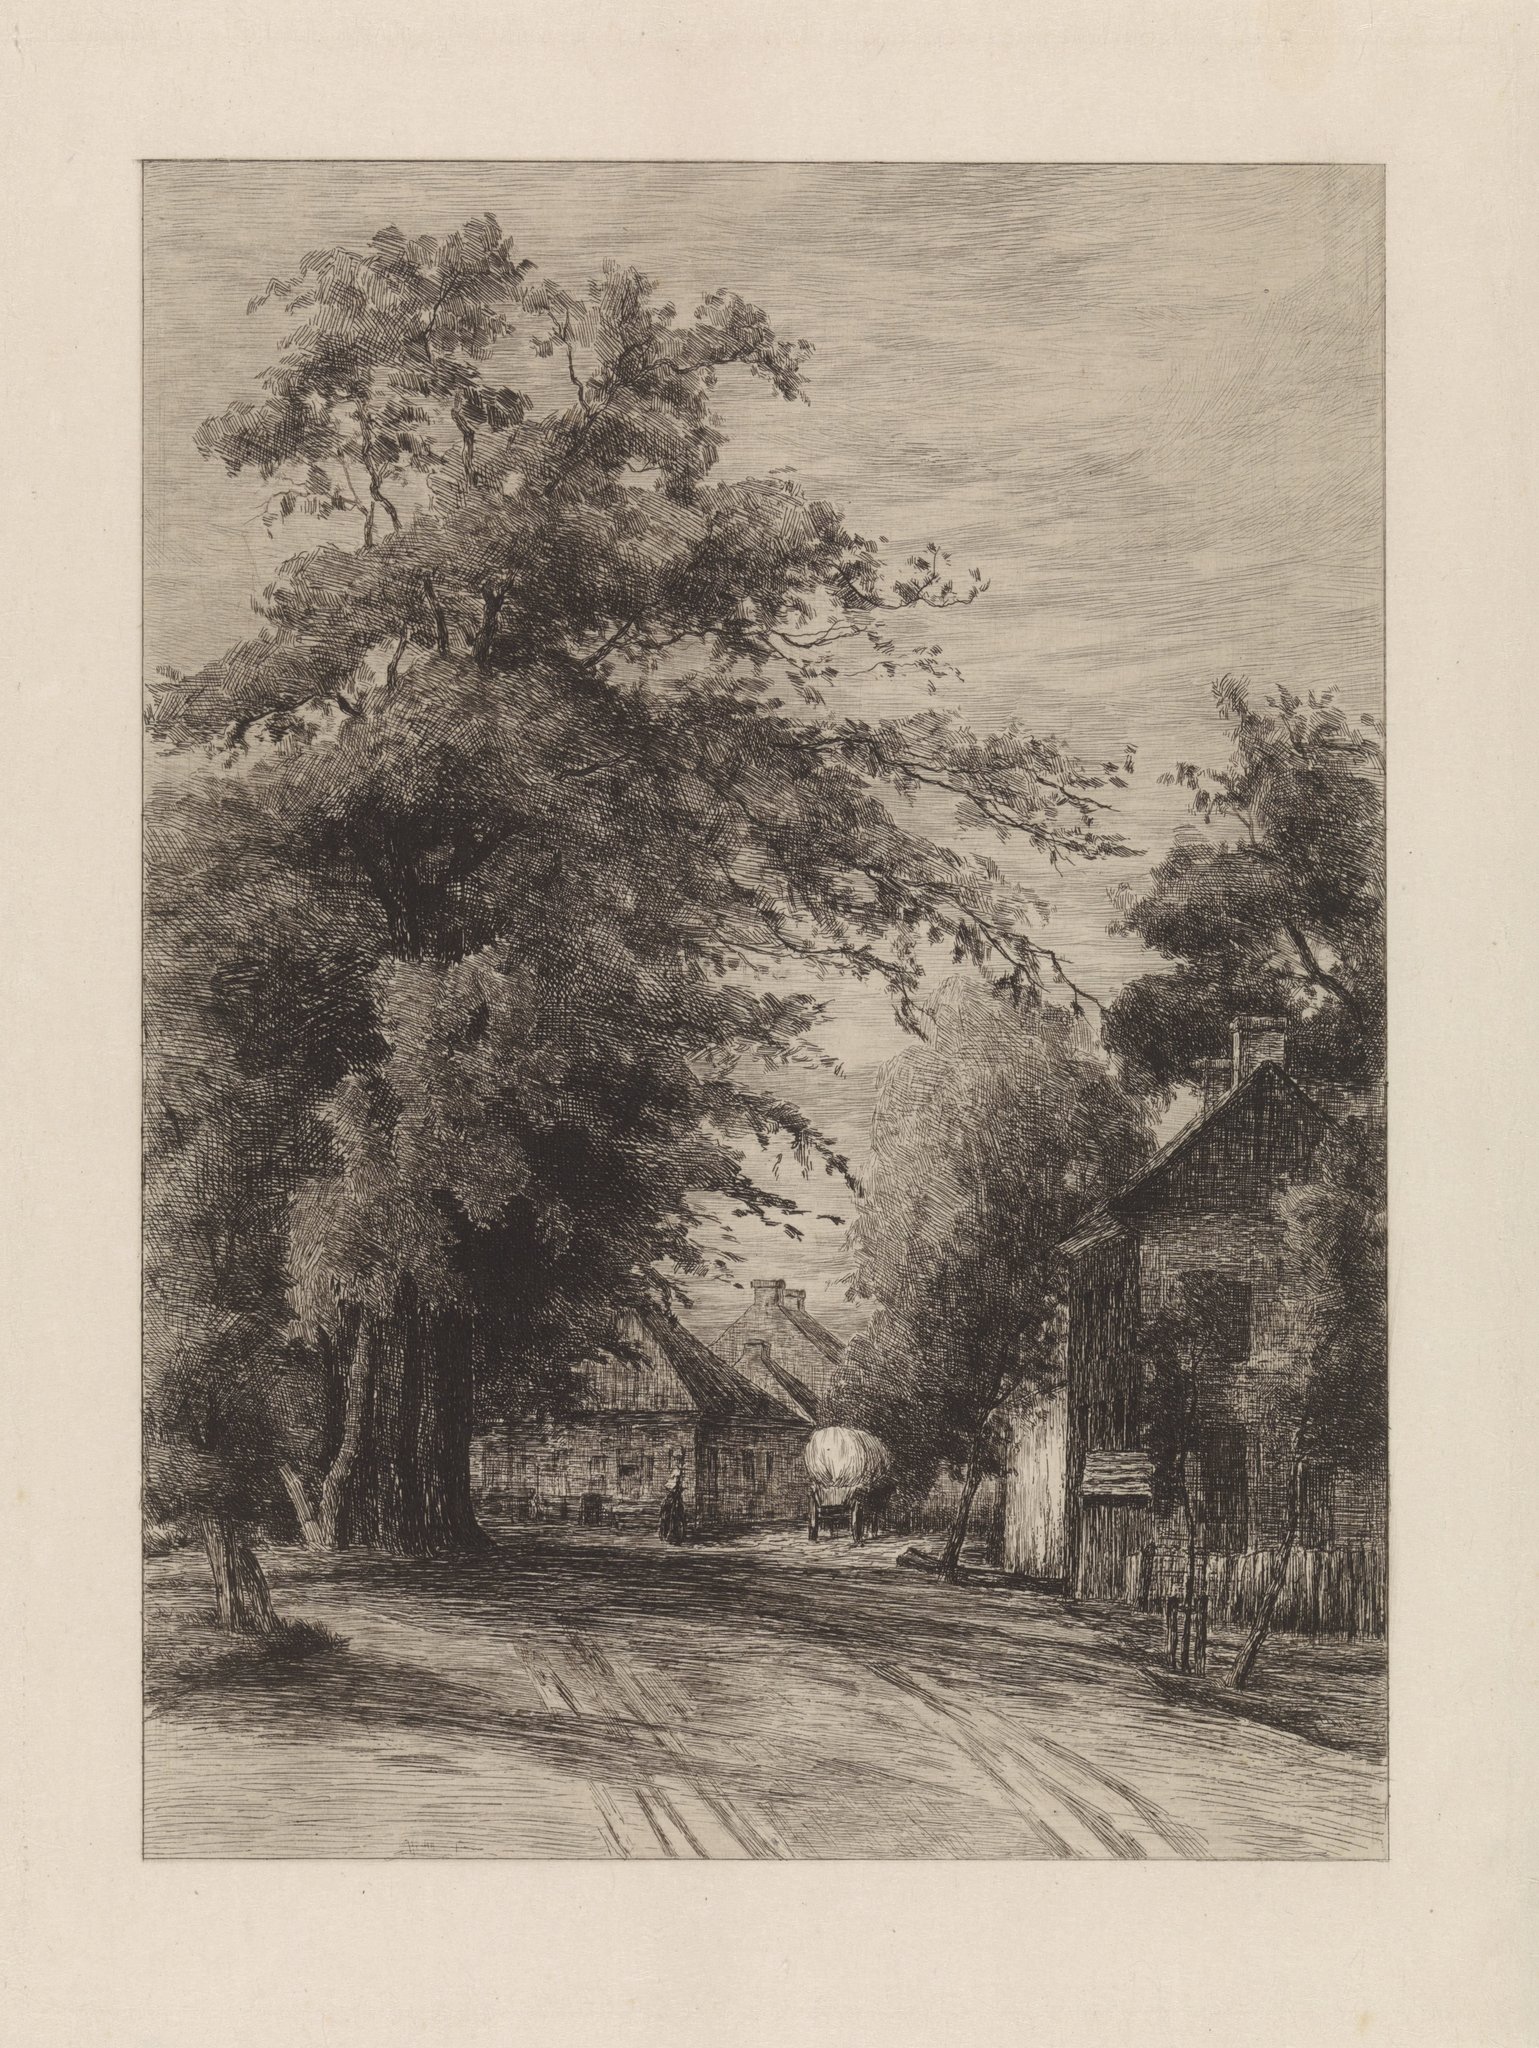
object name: print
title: Dorpsweg met huifkar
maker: willem oppenoorth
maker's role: draughtsman, painter, print maker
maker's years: 1847-1905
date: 1862-1905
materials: paper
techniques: etching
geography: amsterdam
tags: landscapes in the temperate zone, four-wheeled, animal-drawn vehicle, e.g.: cab, carriage, coach, village lane, alley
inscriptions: collector's mark: Lugt 2228